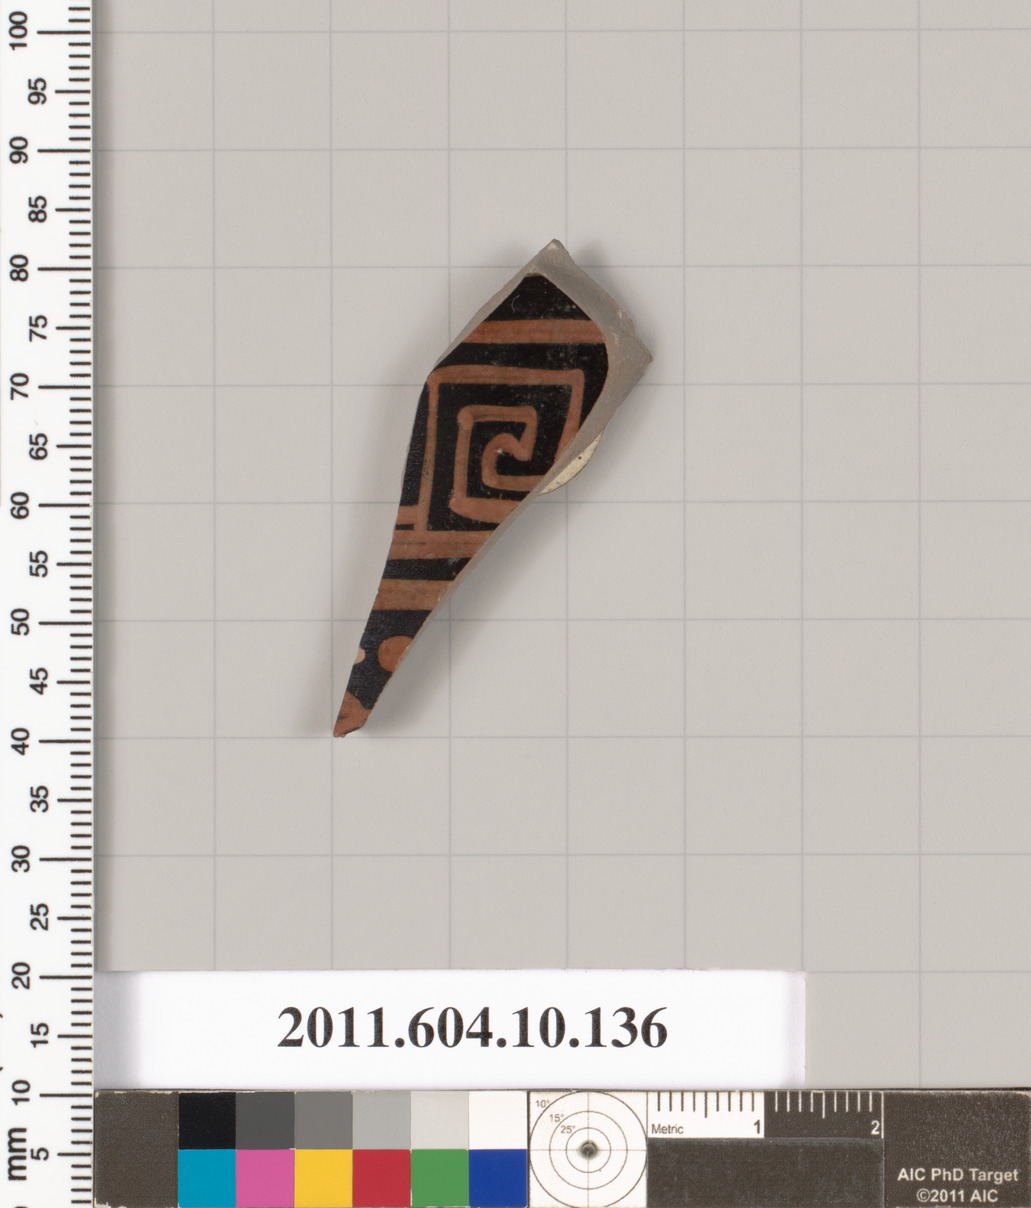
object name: oinochoe fragment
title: Terracotta fragment of an oinochoe (jug)?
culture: etruscan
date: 434-368 BCE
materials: terracotta